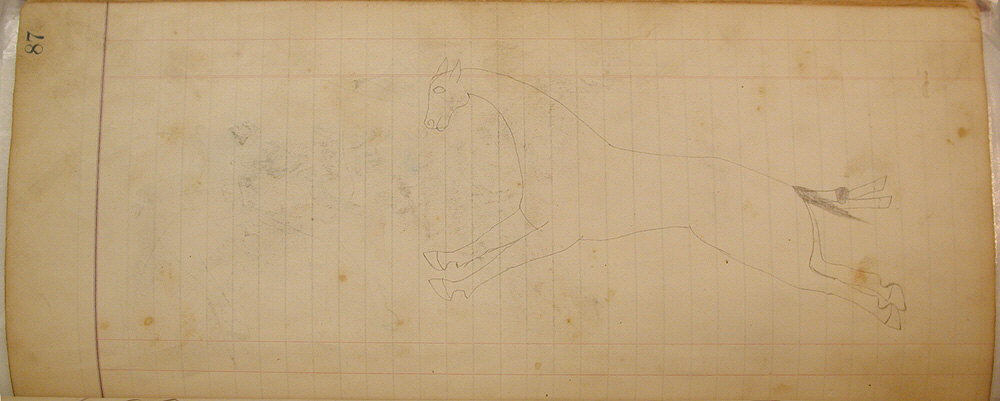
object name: drawing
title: Maffet Ledger: Drawing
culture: cheyenne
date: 1874-1881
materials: crayon, graphite, paper, watercolor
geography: united states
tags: horses